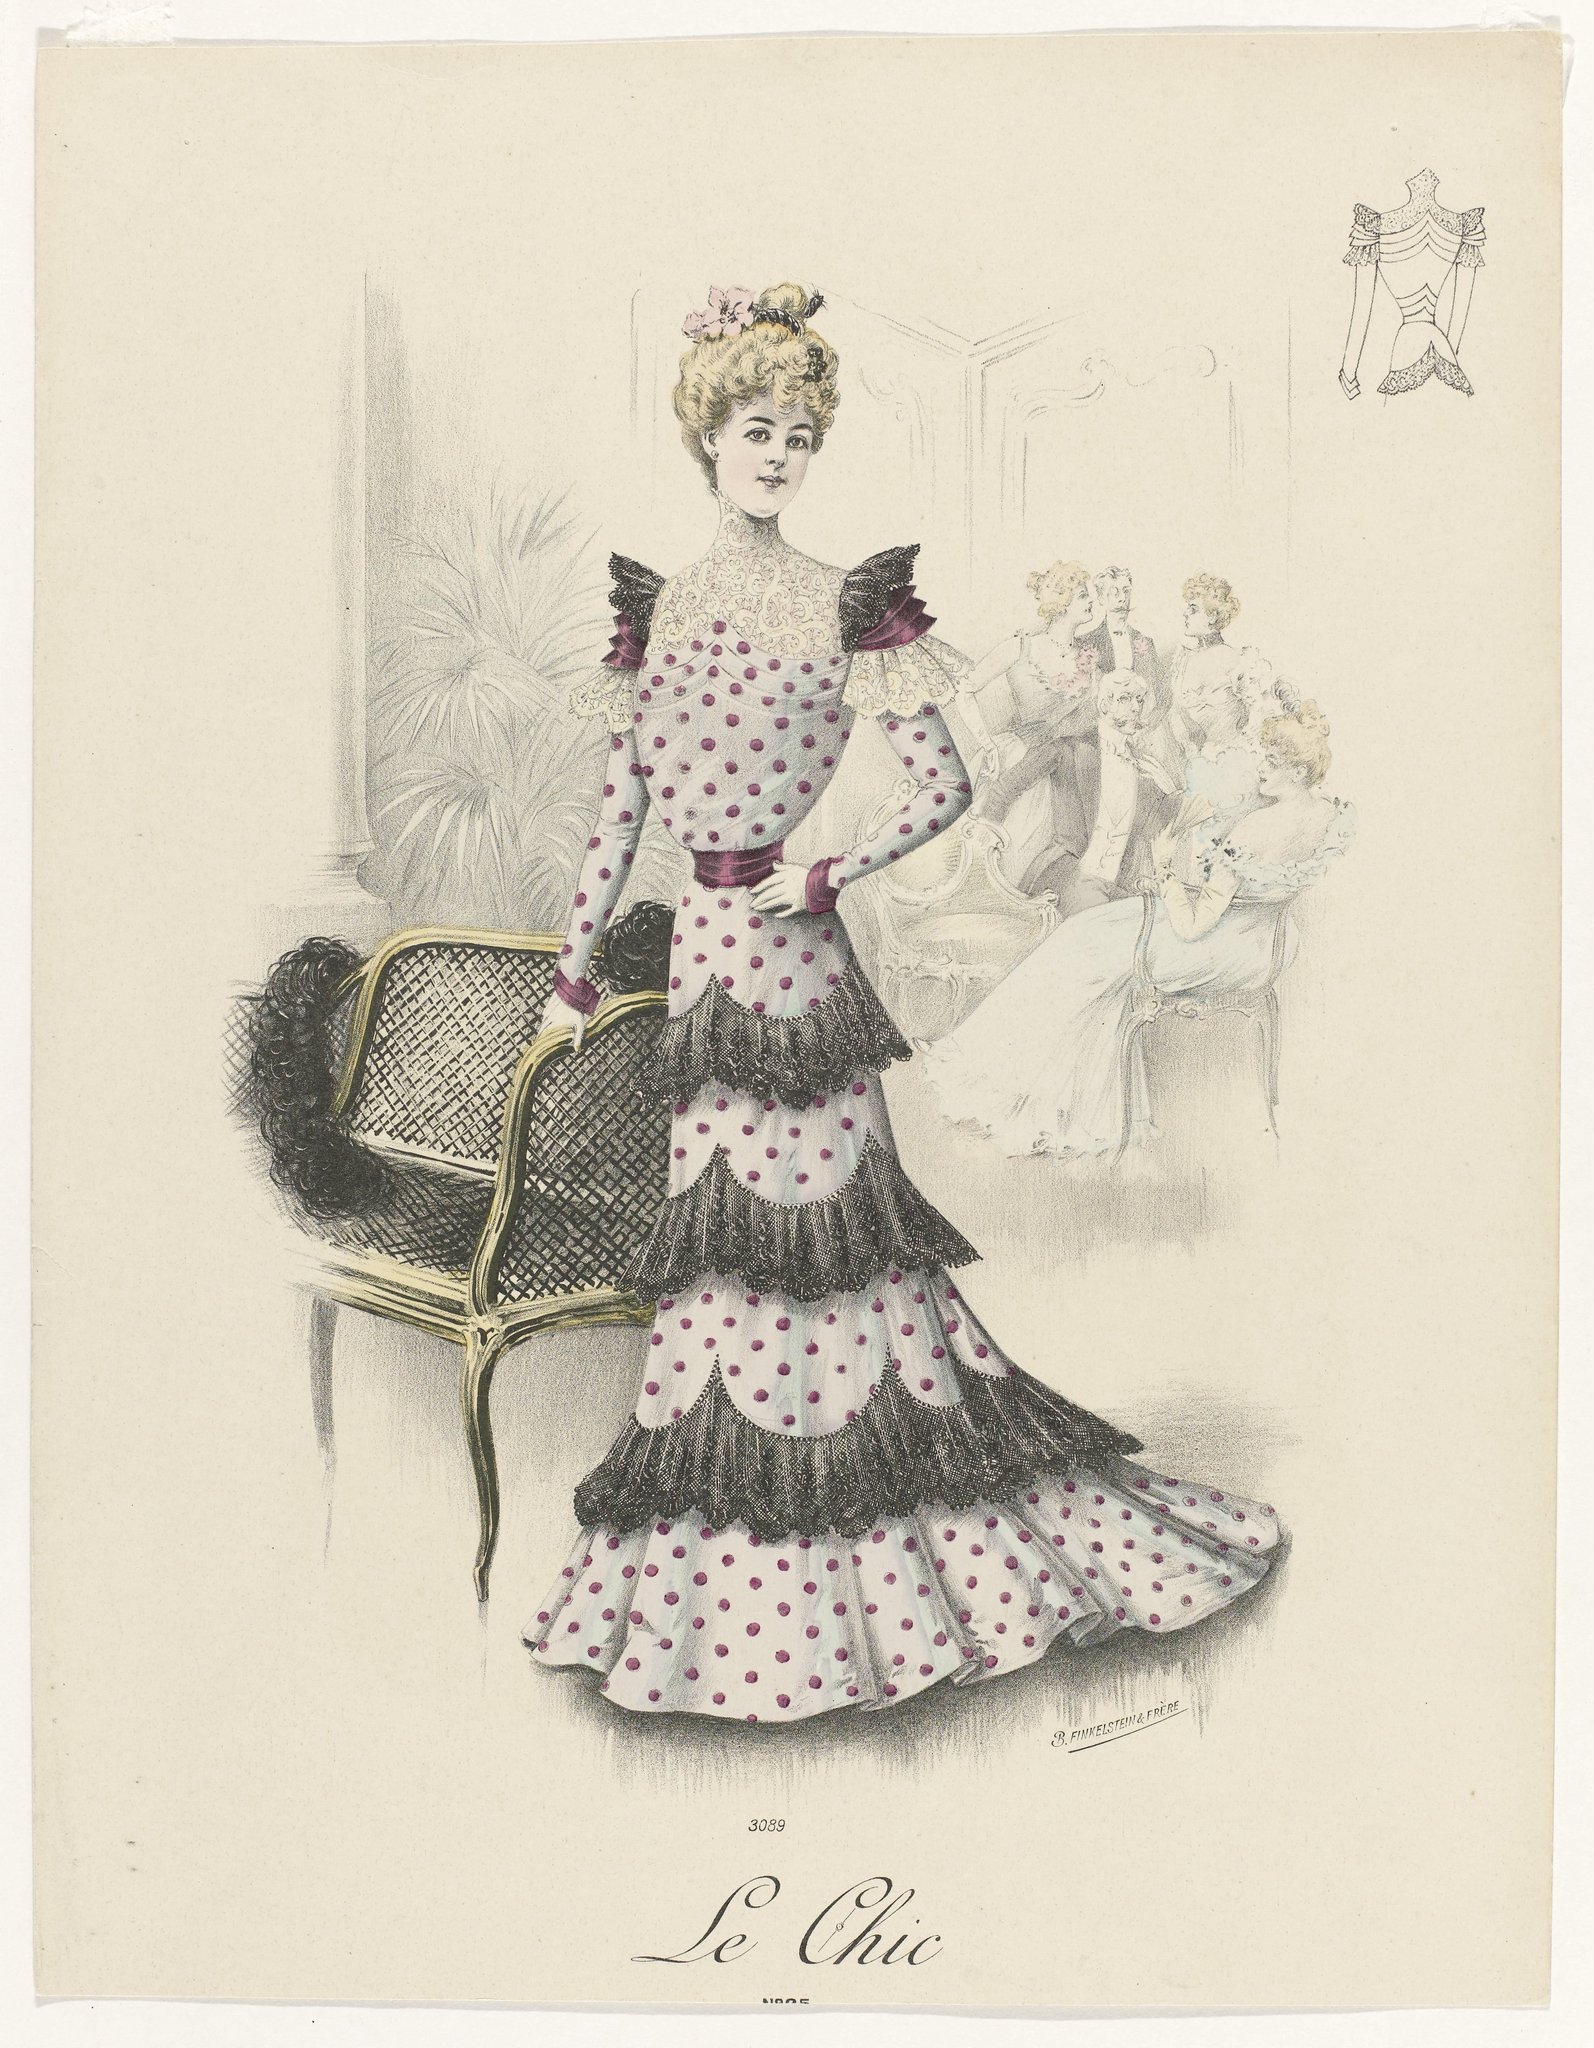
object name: fashion print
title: Le Chic, 1900, No. 2089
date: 1900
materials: paper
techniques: hand coloring, lithograph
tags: dress, gown: evening dress (+ women's clothes), lace (+ women's clothes), clothing for the upper part of the body (boa) (+ fur used for clothes), styles of hairdress - aa - ~ women, fashion plates, private festivities, merry company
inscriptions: title: ‘3089 / Le Chic’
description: Vrouw in een hooggesloten avondjapon met paars stippenmotief. Bij de hals en schouders versierd met wit en zwart kant. Lange mouwen. Rok met sleepje versierd met drie geschulpte stroken zwart kant. Zij staat naast een bank waarover een zwarte stola is gedrapeerd. Op de achtergrond een elegant gezelschap in avondkleding. Rechtsboven een lijntekening van de achterkant van het japonlijfje.